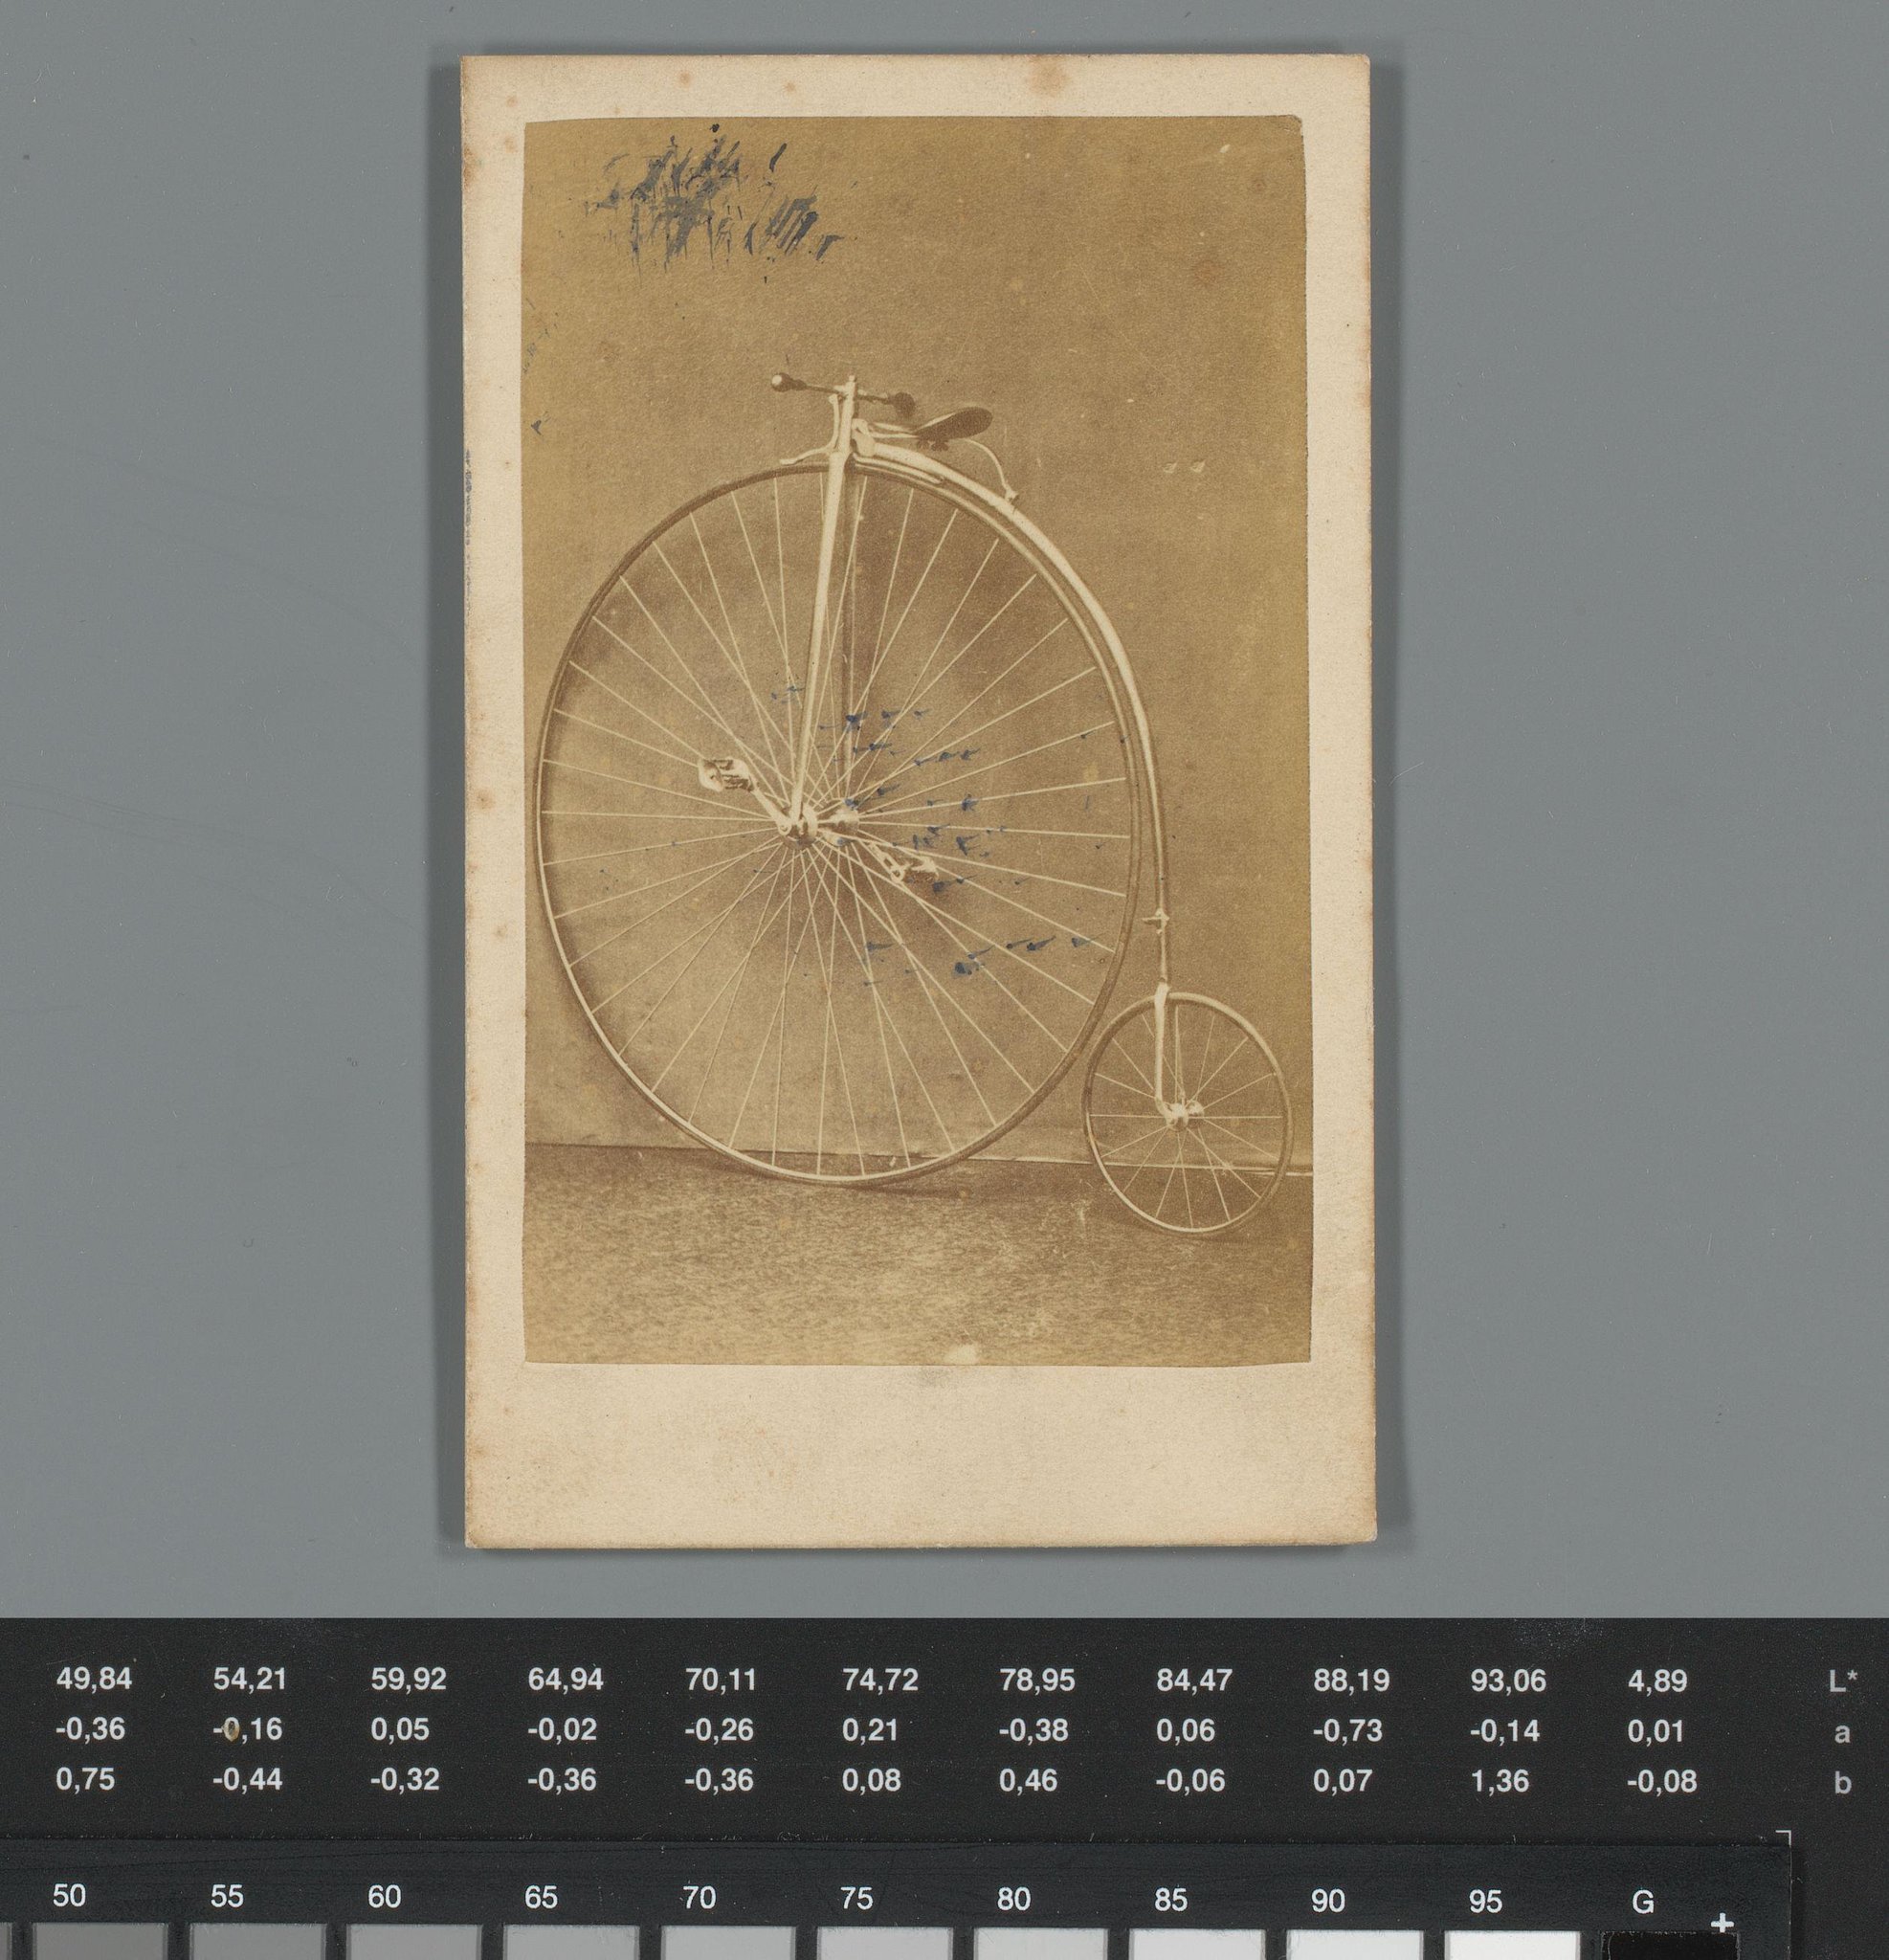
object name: photograph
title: Reclame voor een fiets van A. Markham in Shepherds Bush, Londen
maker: Anonymous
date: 1850-1915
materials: cardboard, photographic support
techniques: albumen print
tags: advertising, antique types of bicycles, london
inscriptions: inscription: ‘A. MARKHAM./ (...)’